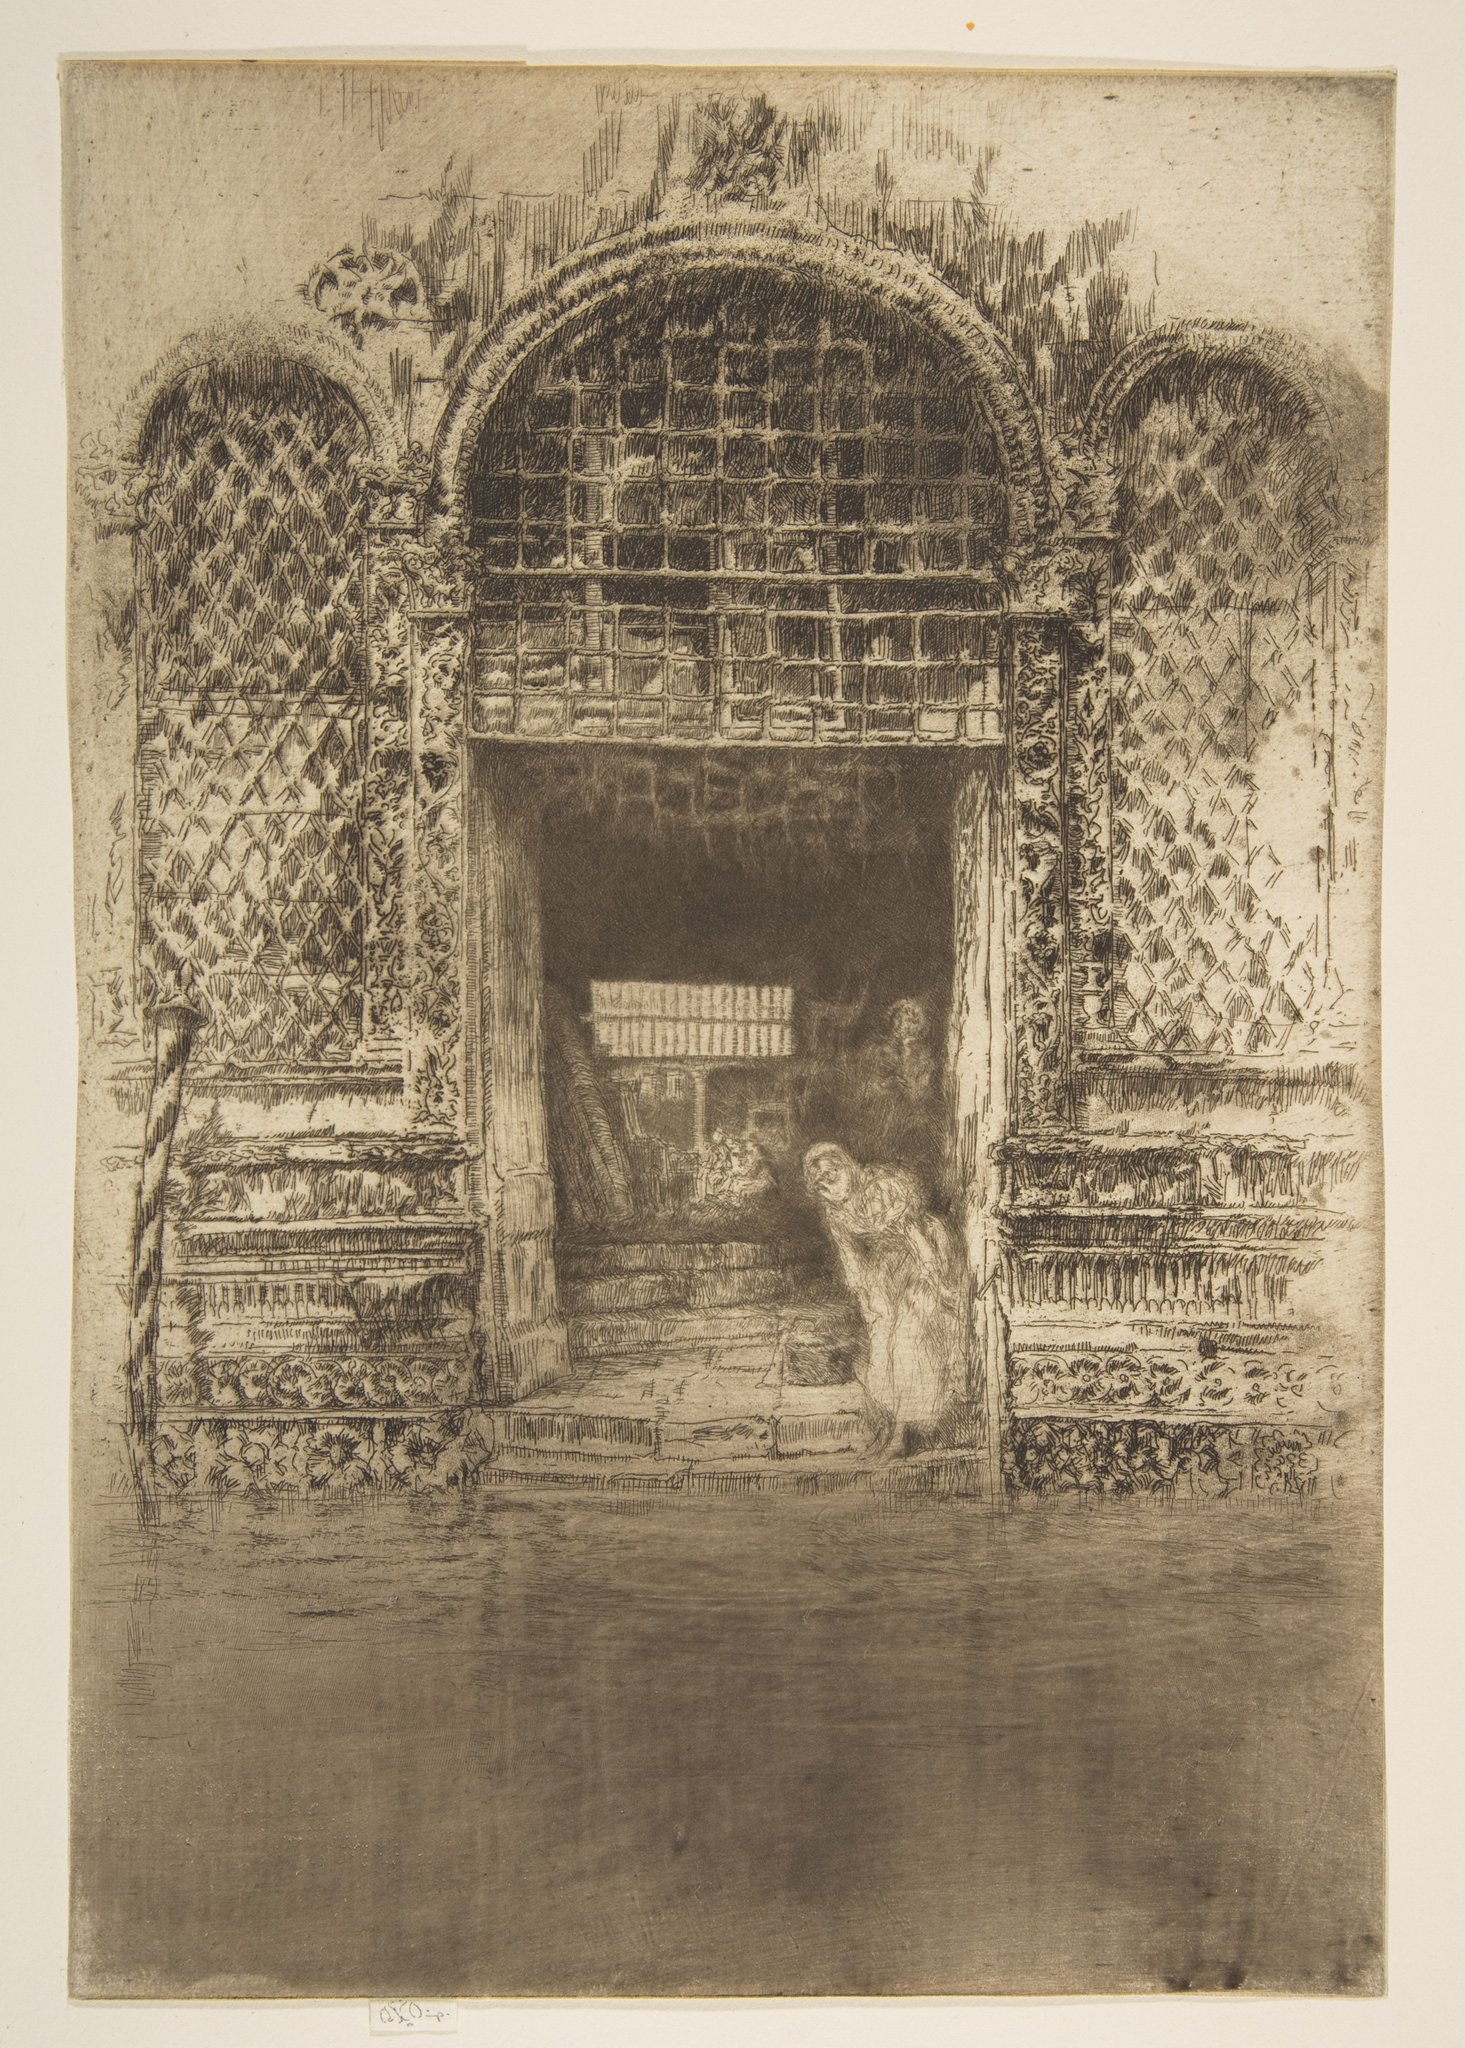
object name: print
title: The Doorway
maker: james mcneill whistler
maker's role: artist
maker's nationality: american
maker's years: 1834-1903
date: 1879-1880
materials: ink, paper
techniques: drypoint, etching, printing, roulette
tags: doorways,women,venice